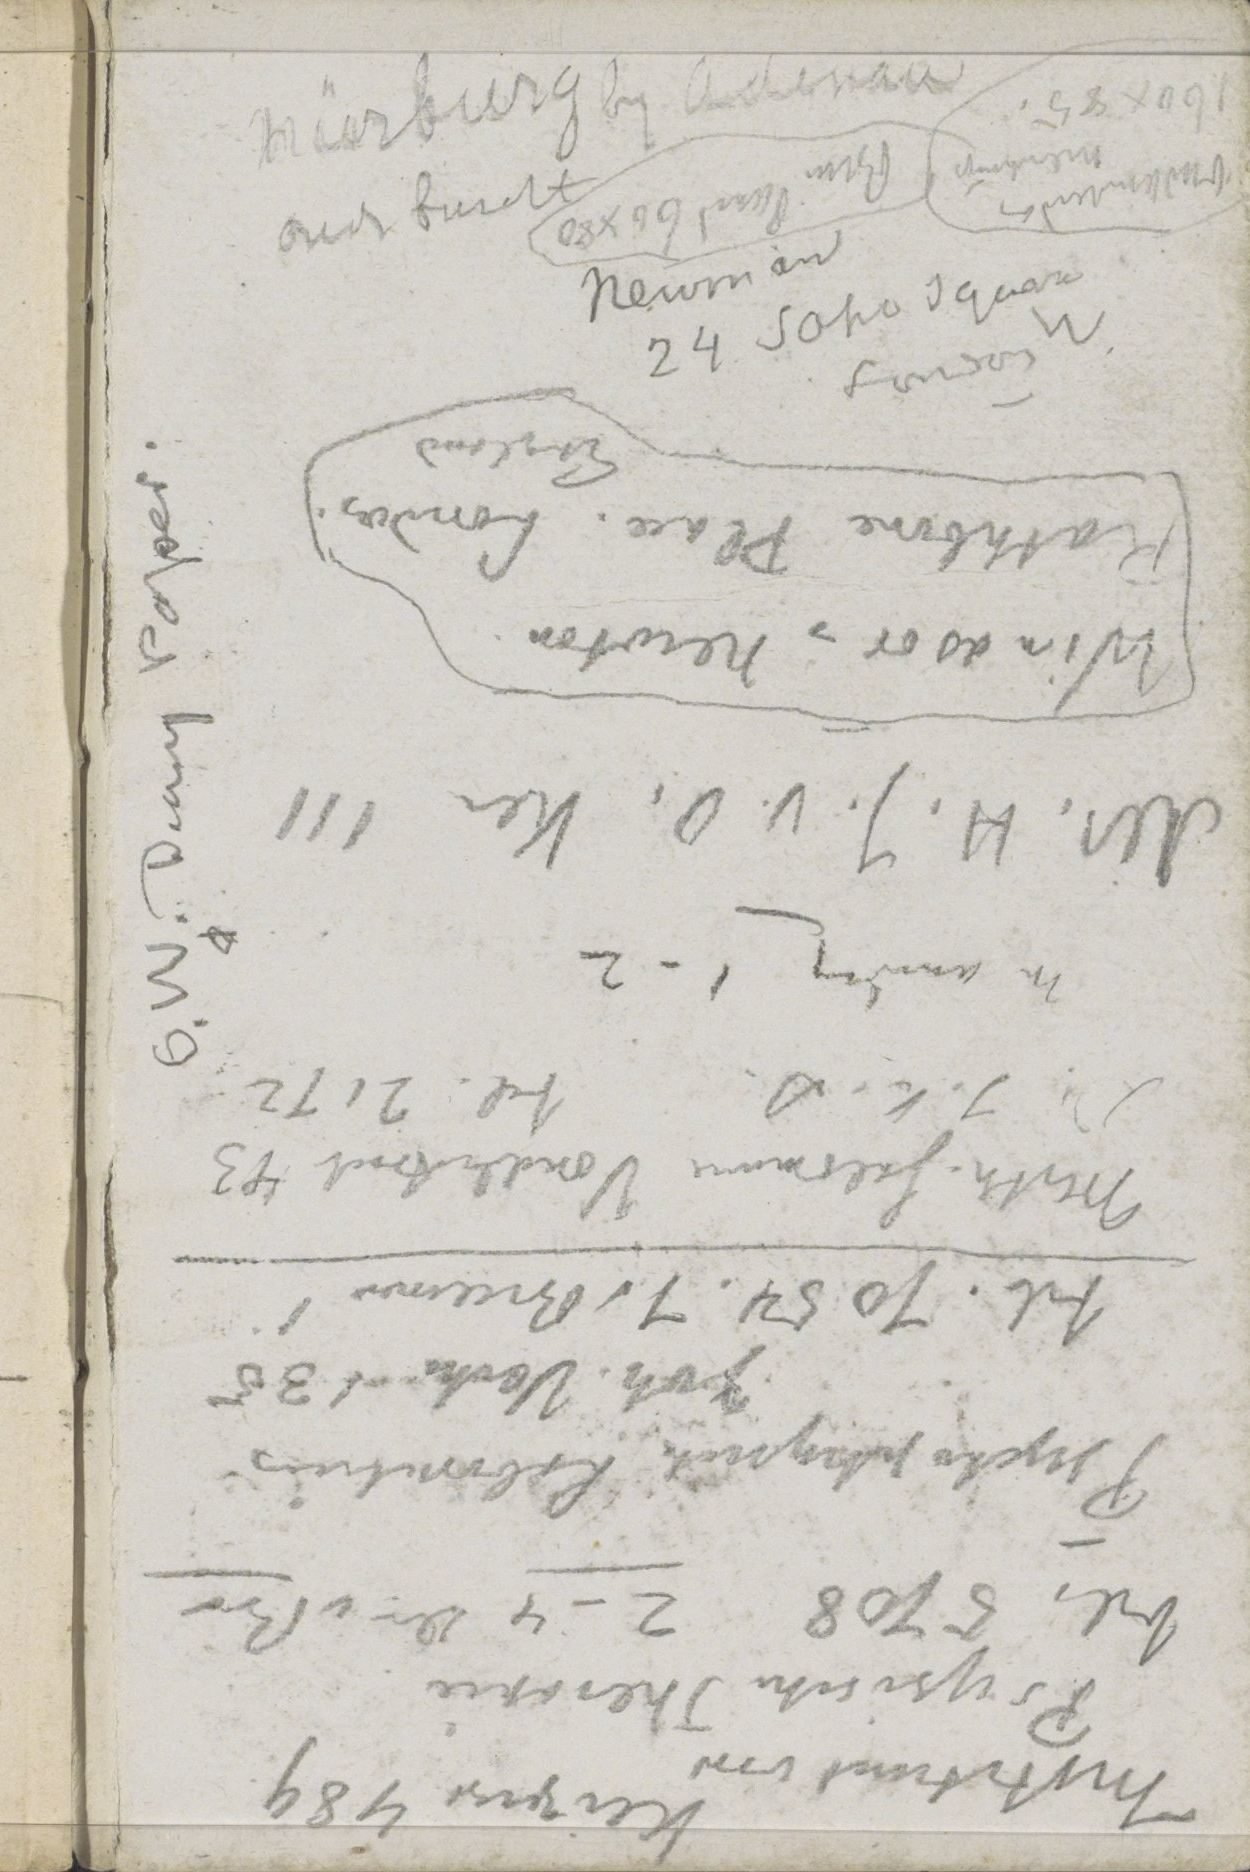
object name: endleaf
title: Annotaties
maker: george hendrik breitner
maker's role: draughtsman, painter, print maker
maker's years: 1857-1923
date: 1909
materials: paper, pencil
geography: amsterdam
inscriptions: address: ‘Newman/ 24 Soho Square/ London W.’, address: ‘Keizergr 489/ Instituut voor/ Psychische Therapie/ tel[?] 5708 2-4 Dr. v. B[...]’, address: ‘Psycho[...] Libortius[?]/ Joh. V[...] 135/ tel 7054 I. v. Breemen’, annotation: ‘G.W. Diary Paper’, address: ‘Windsor-Newton/ Rathbone Place. London/ England’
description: Aantekeningen. Pagina 92 uit een schetsboek met 45 bladen vervaardigd in Amsterdam en Pittsburgh.